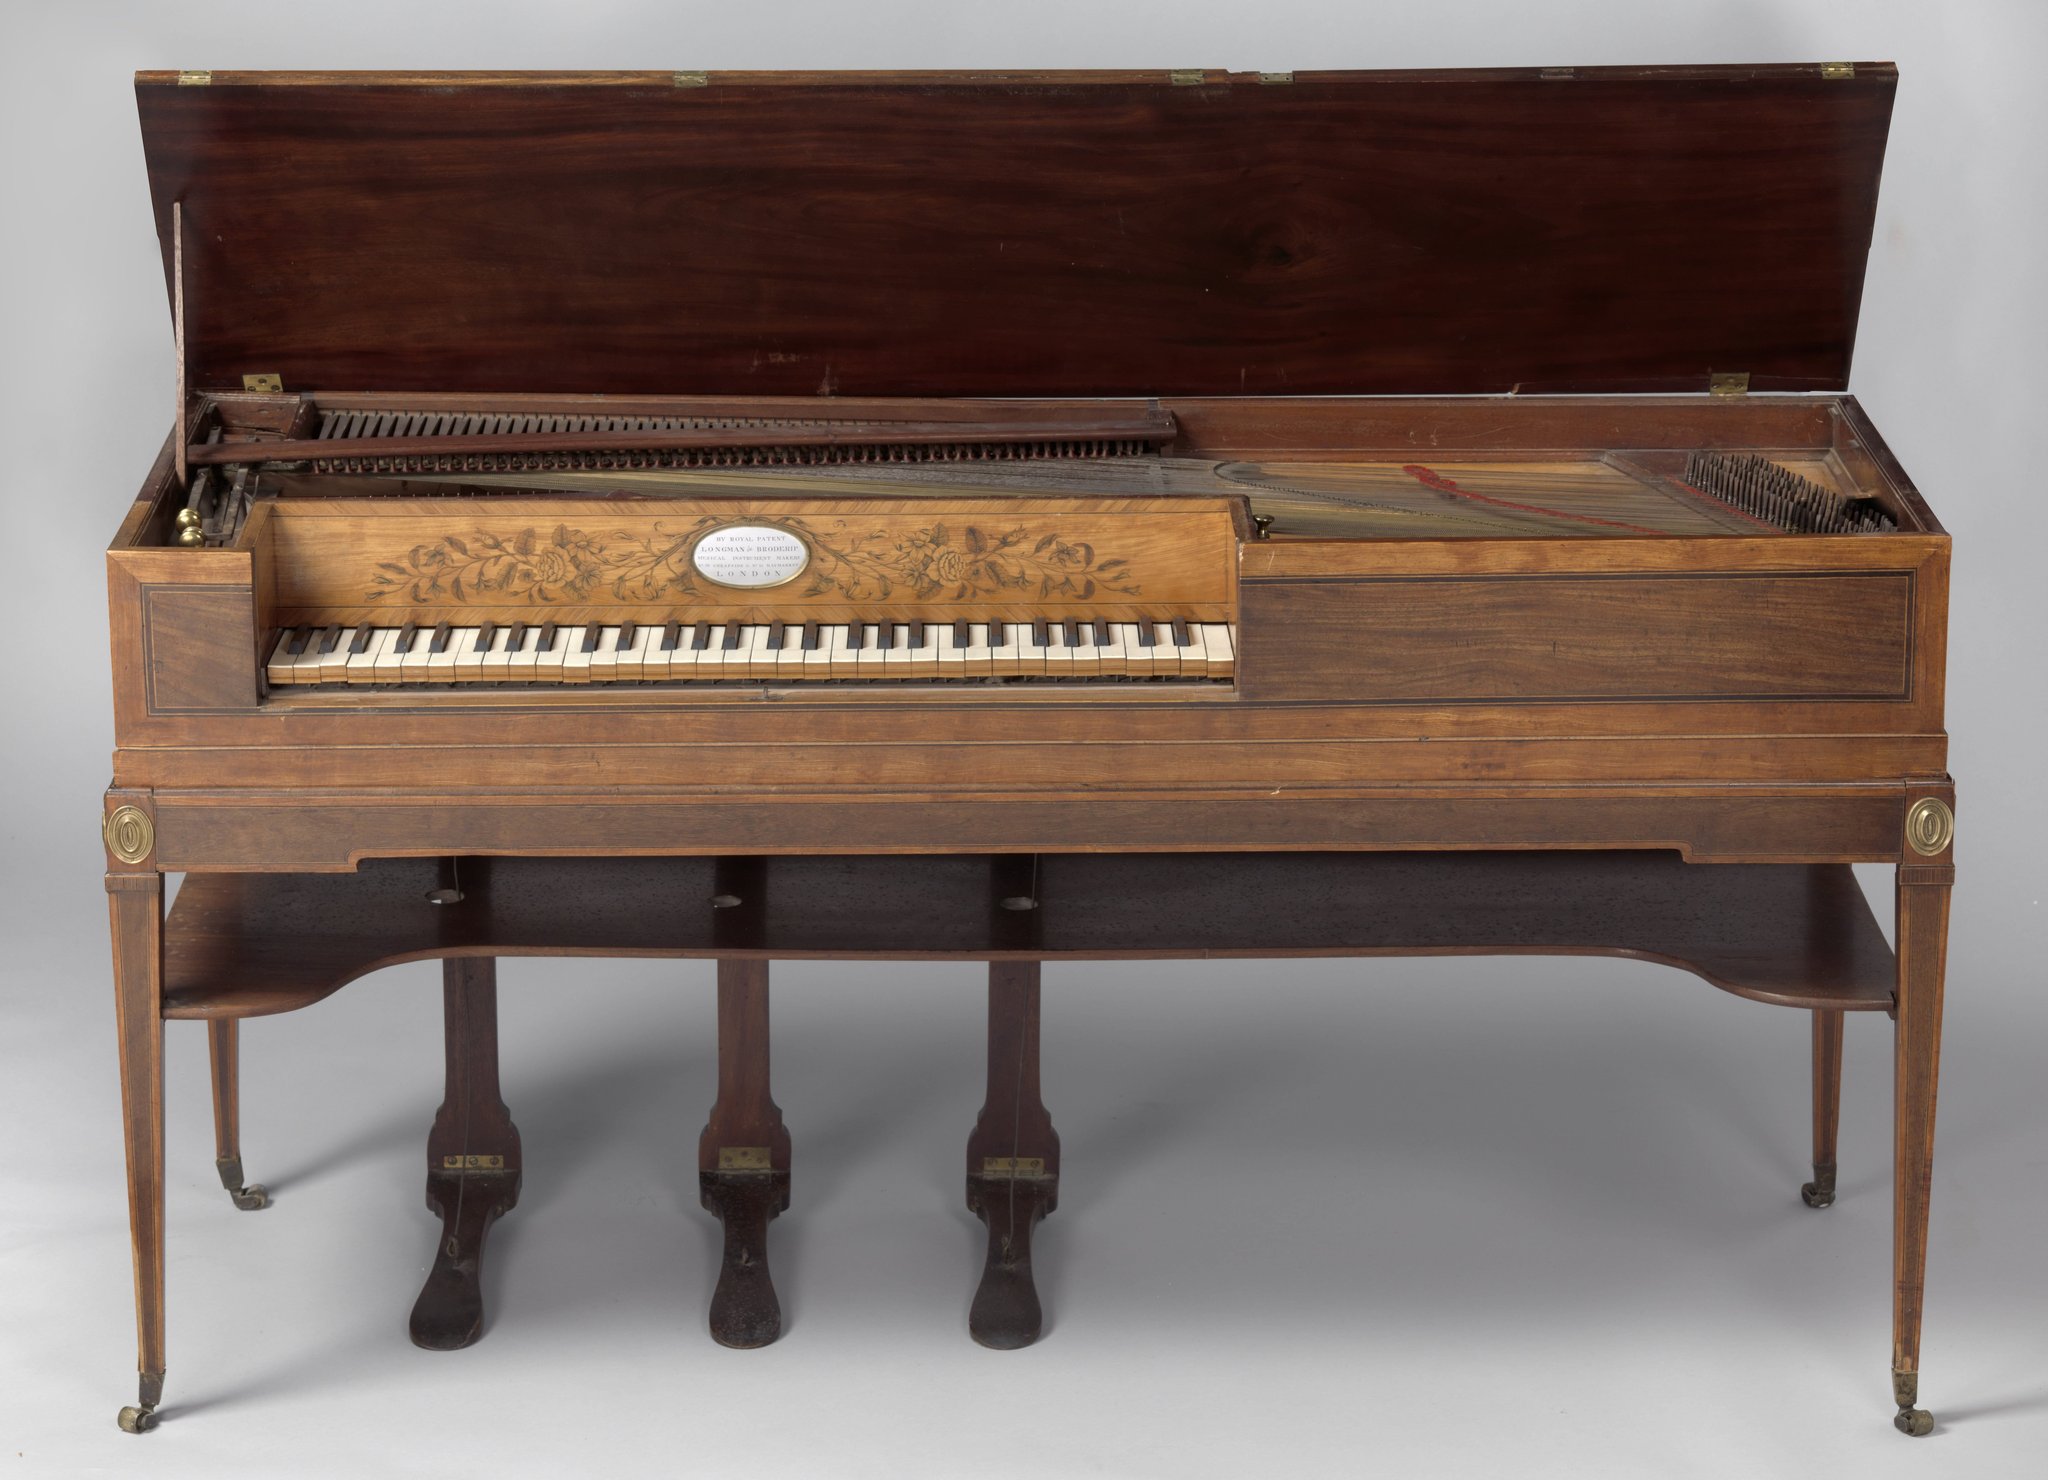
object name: square piano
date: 1782-1798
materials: copper, ivory, wood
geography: london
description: Piano op vier poten, met ornamenten van koper en aan de binnenzijde ingelegd met kleurige bloemen van hout. Vijf octaafs; drie pedalen. Gemerkt: LONGMAN AND BRODERIP, LONDON.